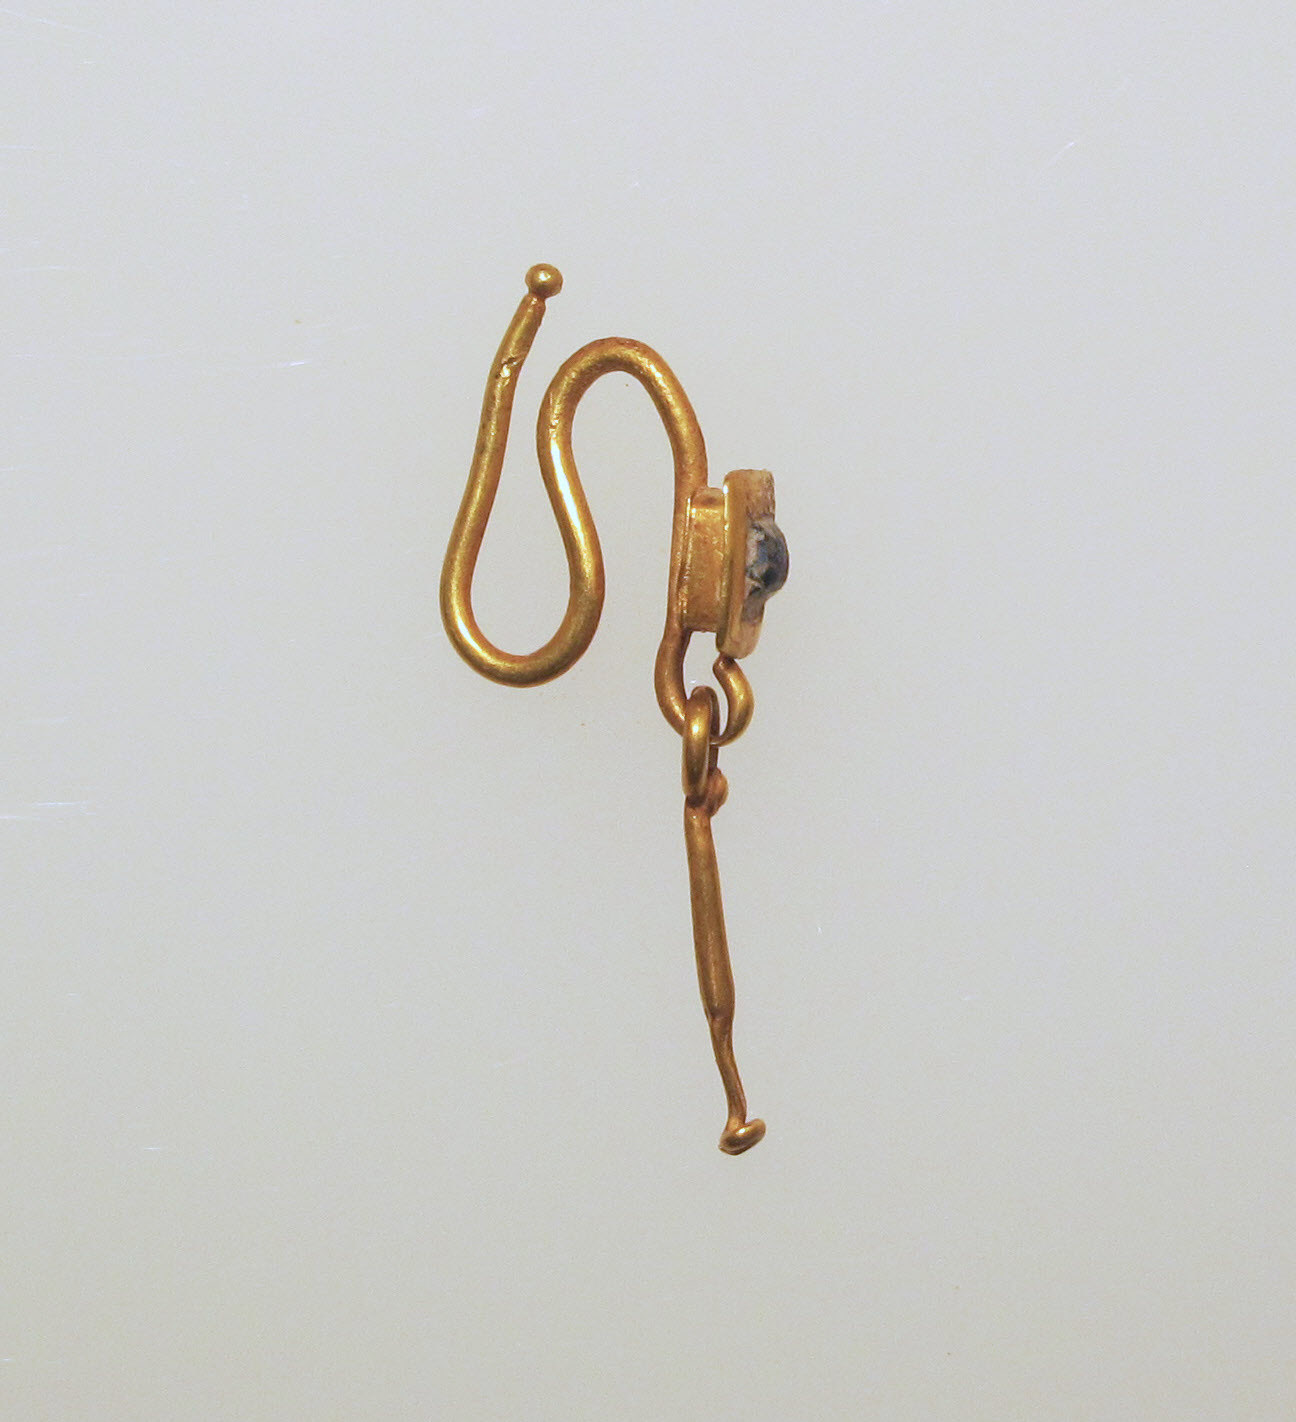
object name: earring hook type with pendant and paste setting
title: Gold earring with pendant and paste setting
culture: roman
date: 101-200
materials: glass, gold, paste